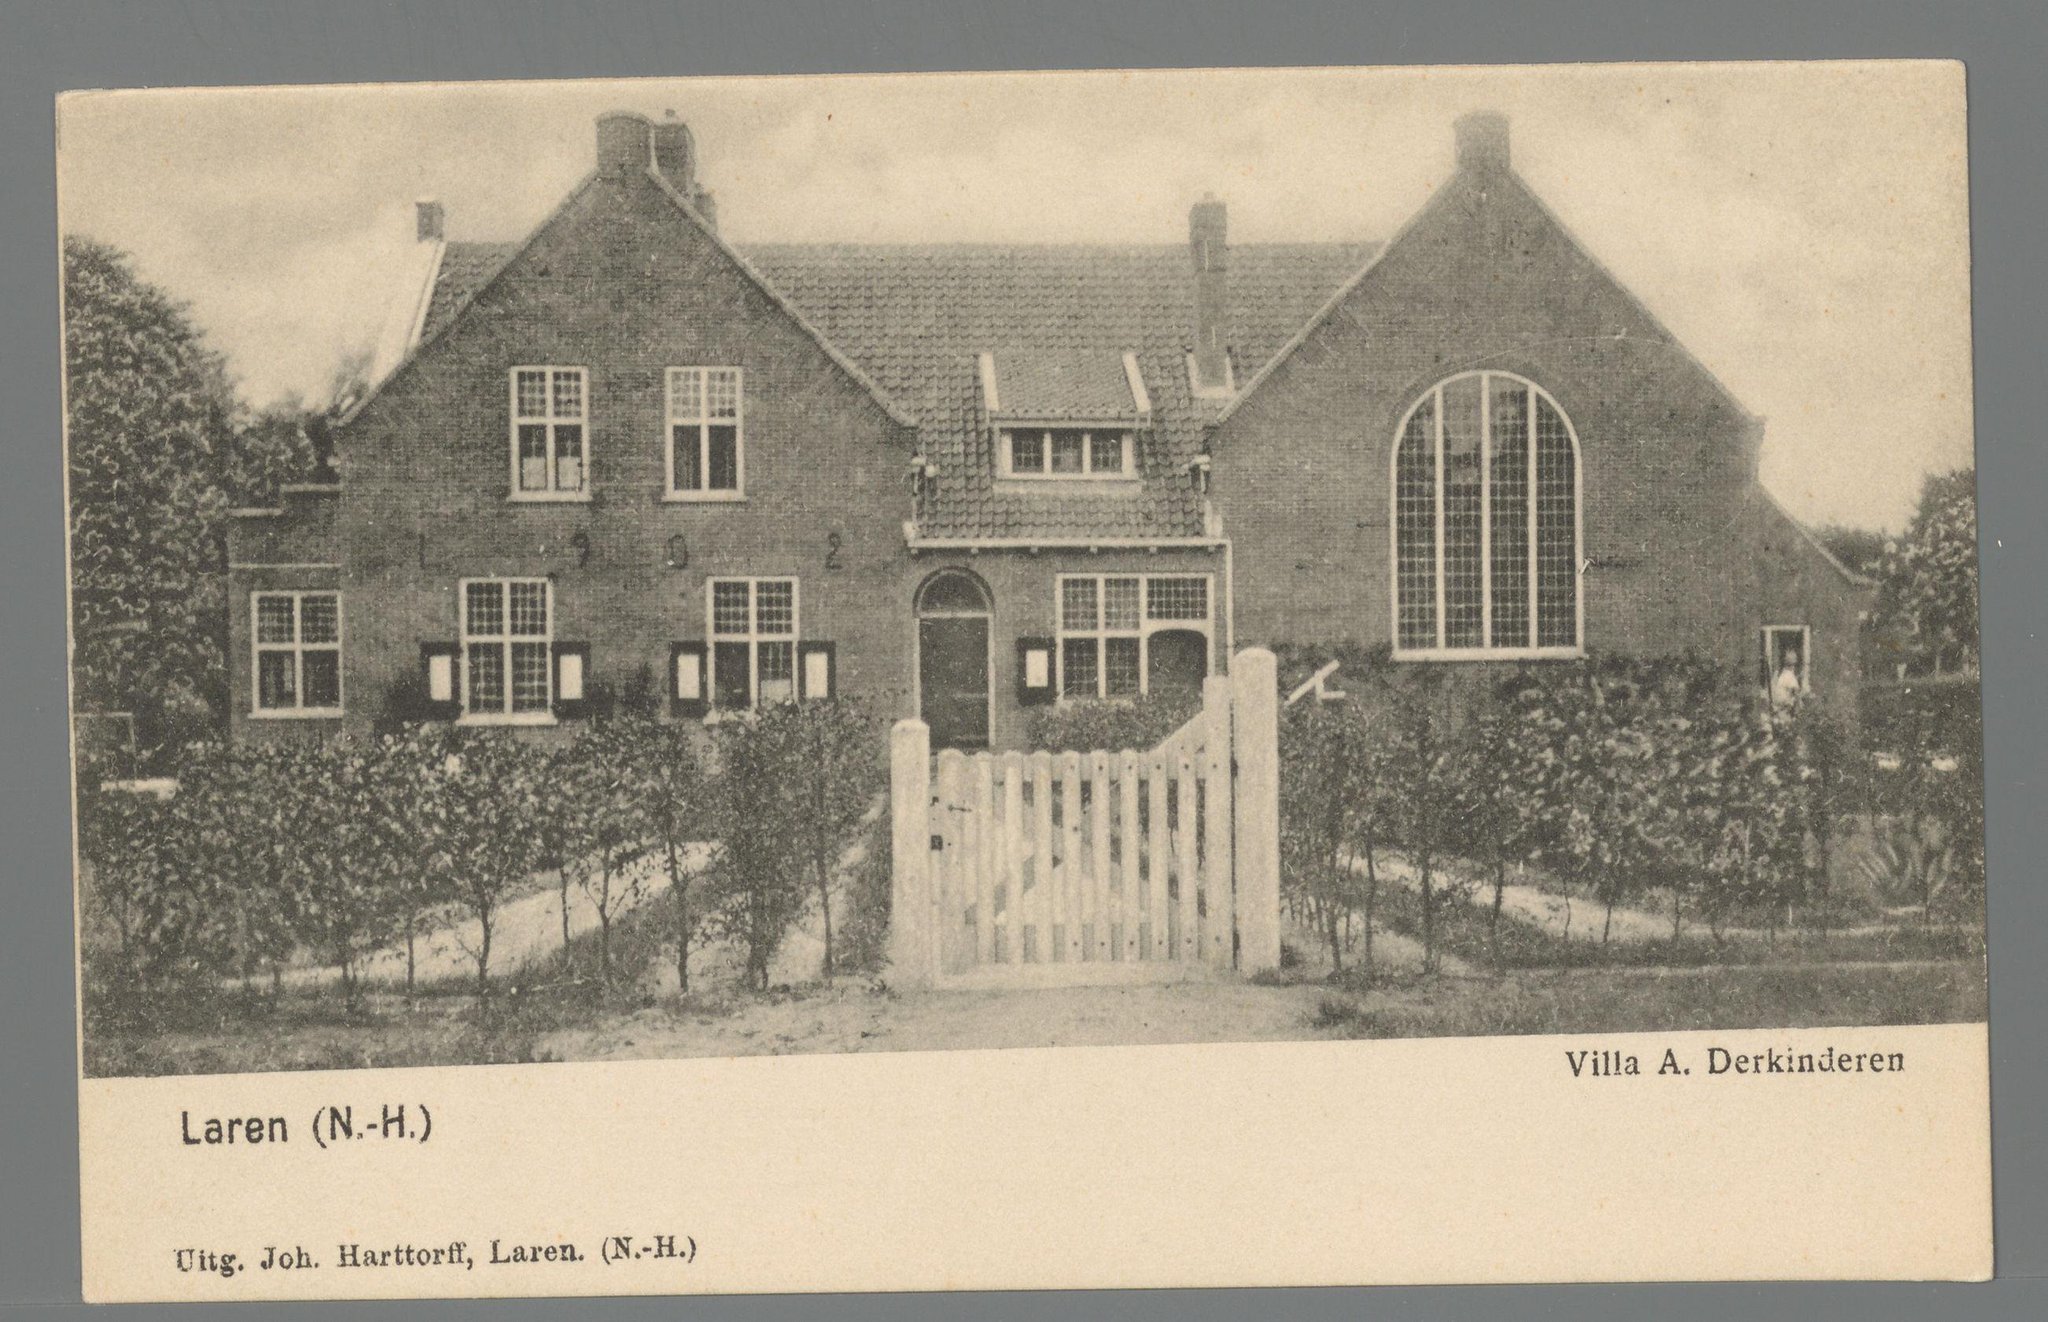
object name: photomechanical print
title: Laren (N.-H.). Villa A. Derkinderen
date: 1902-1905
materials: cardboard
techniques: photograph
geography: laren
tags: villa